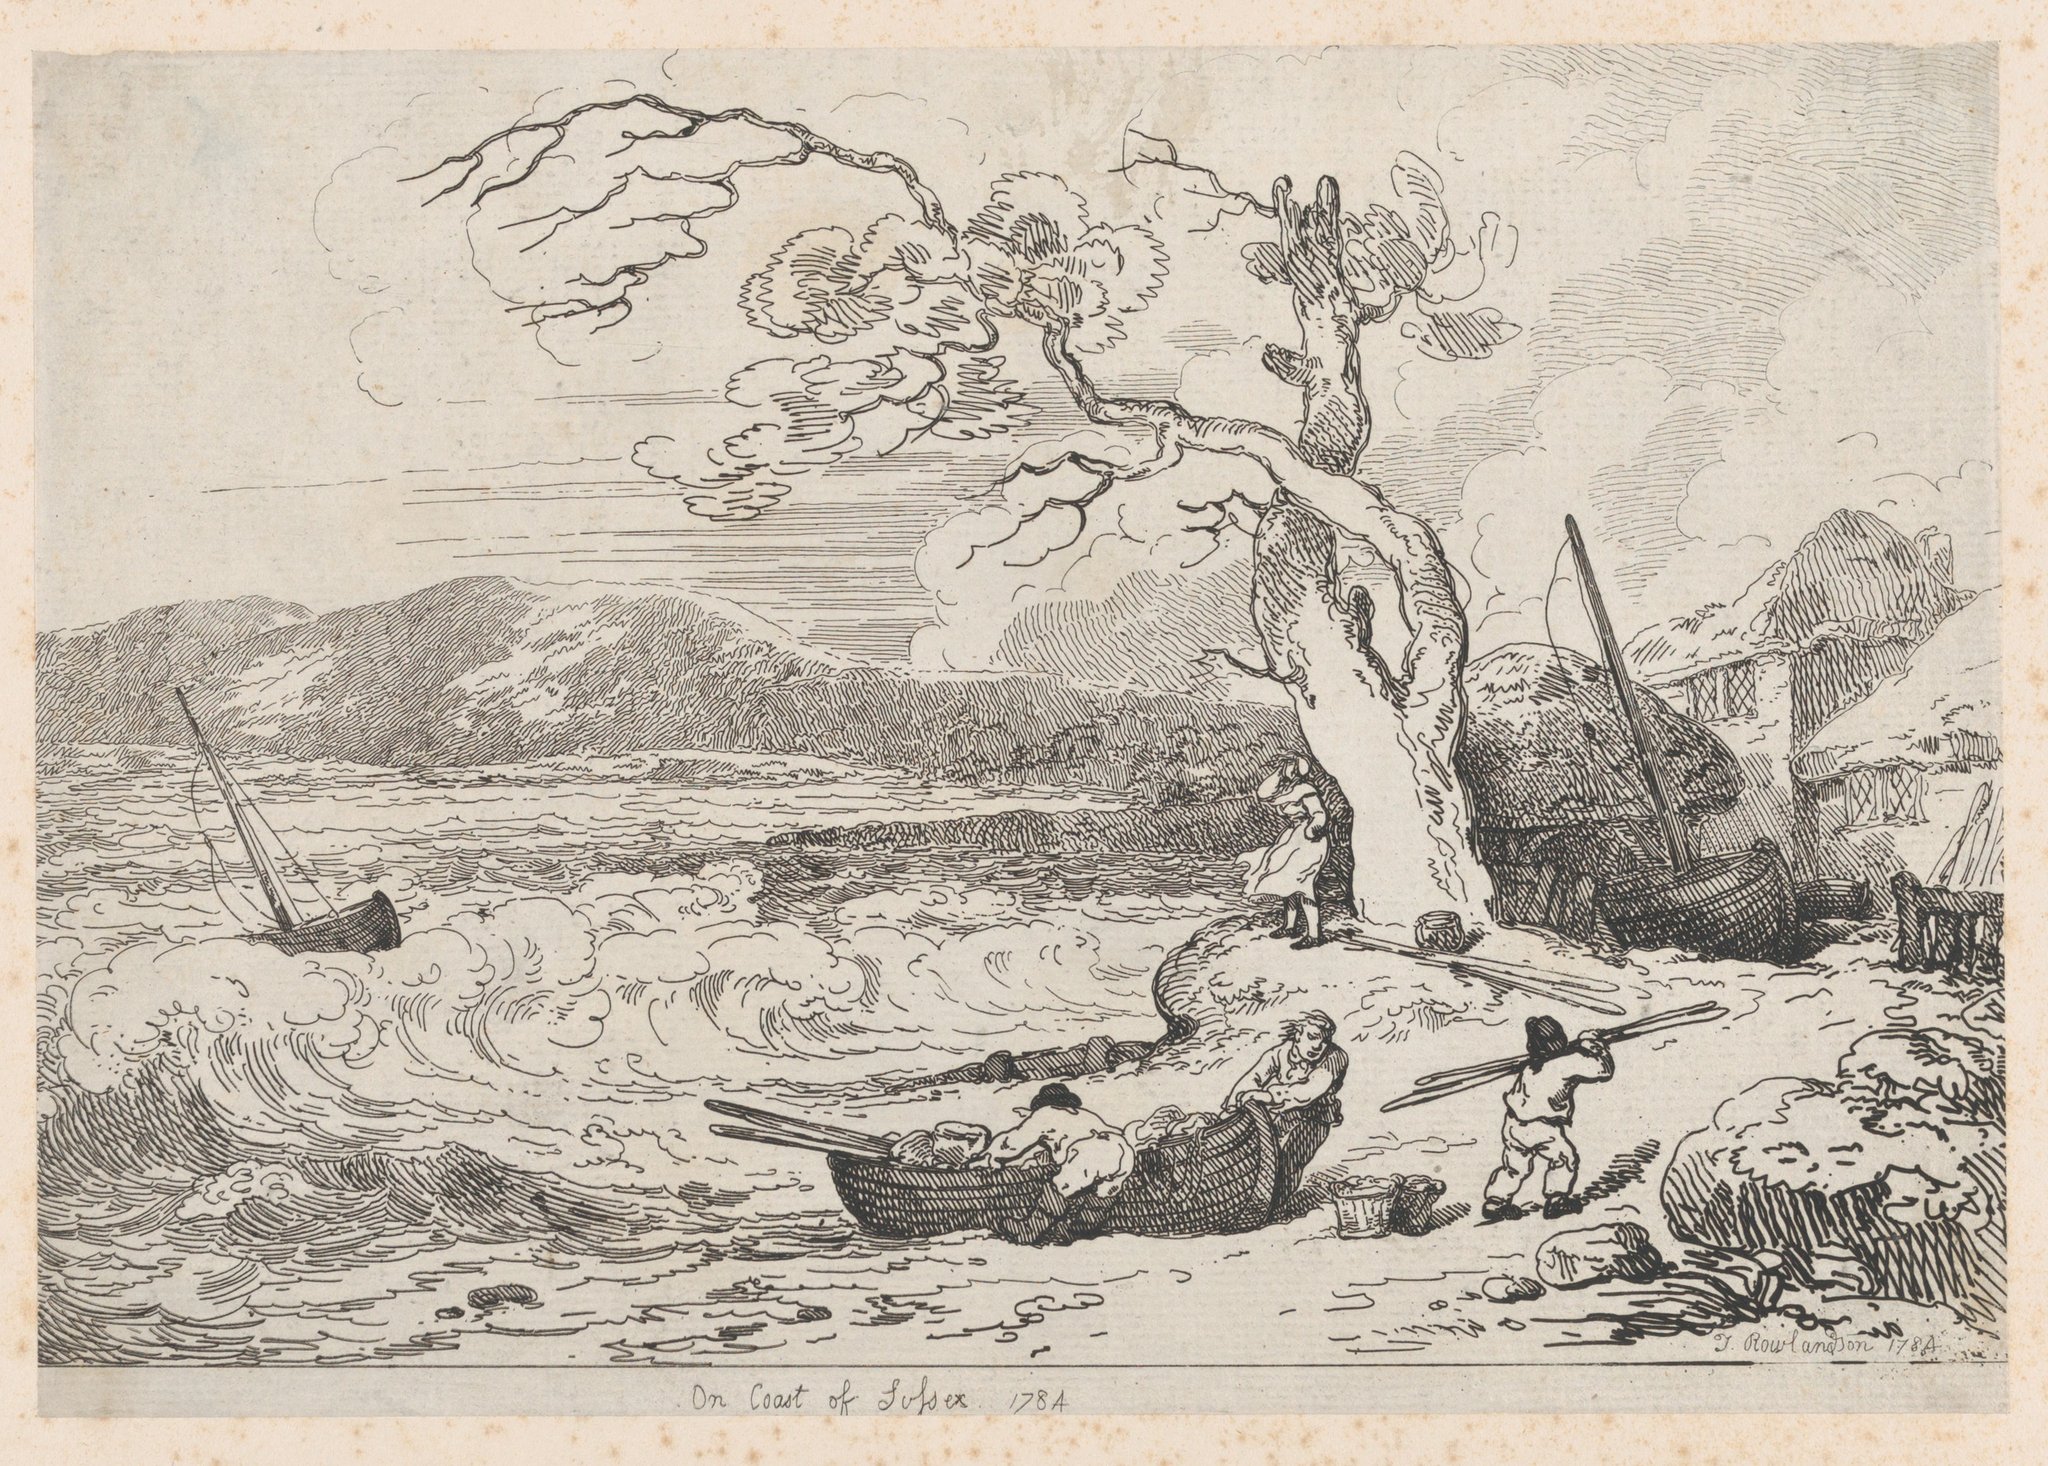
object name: print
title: On Coast of Sussex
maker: thomas rowlandson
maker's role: artist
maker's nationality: british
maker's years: 1757-1827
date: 1784-1785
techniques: etching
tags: seas,trees,boats